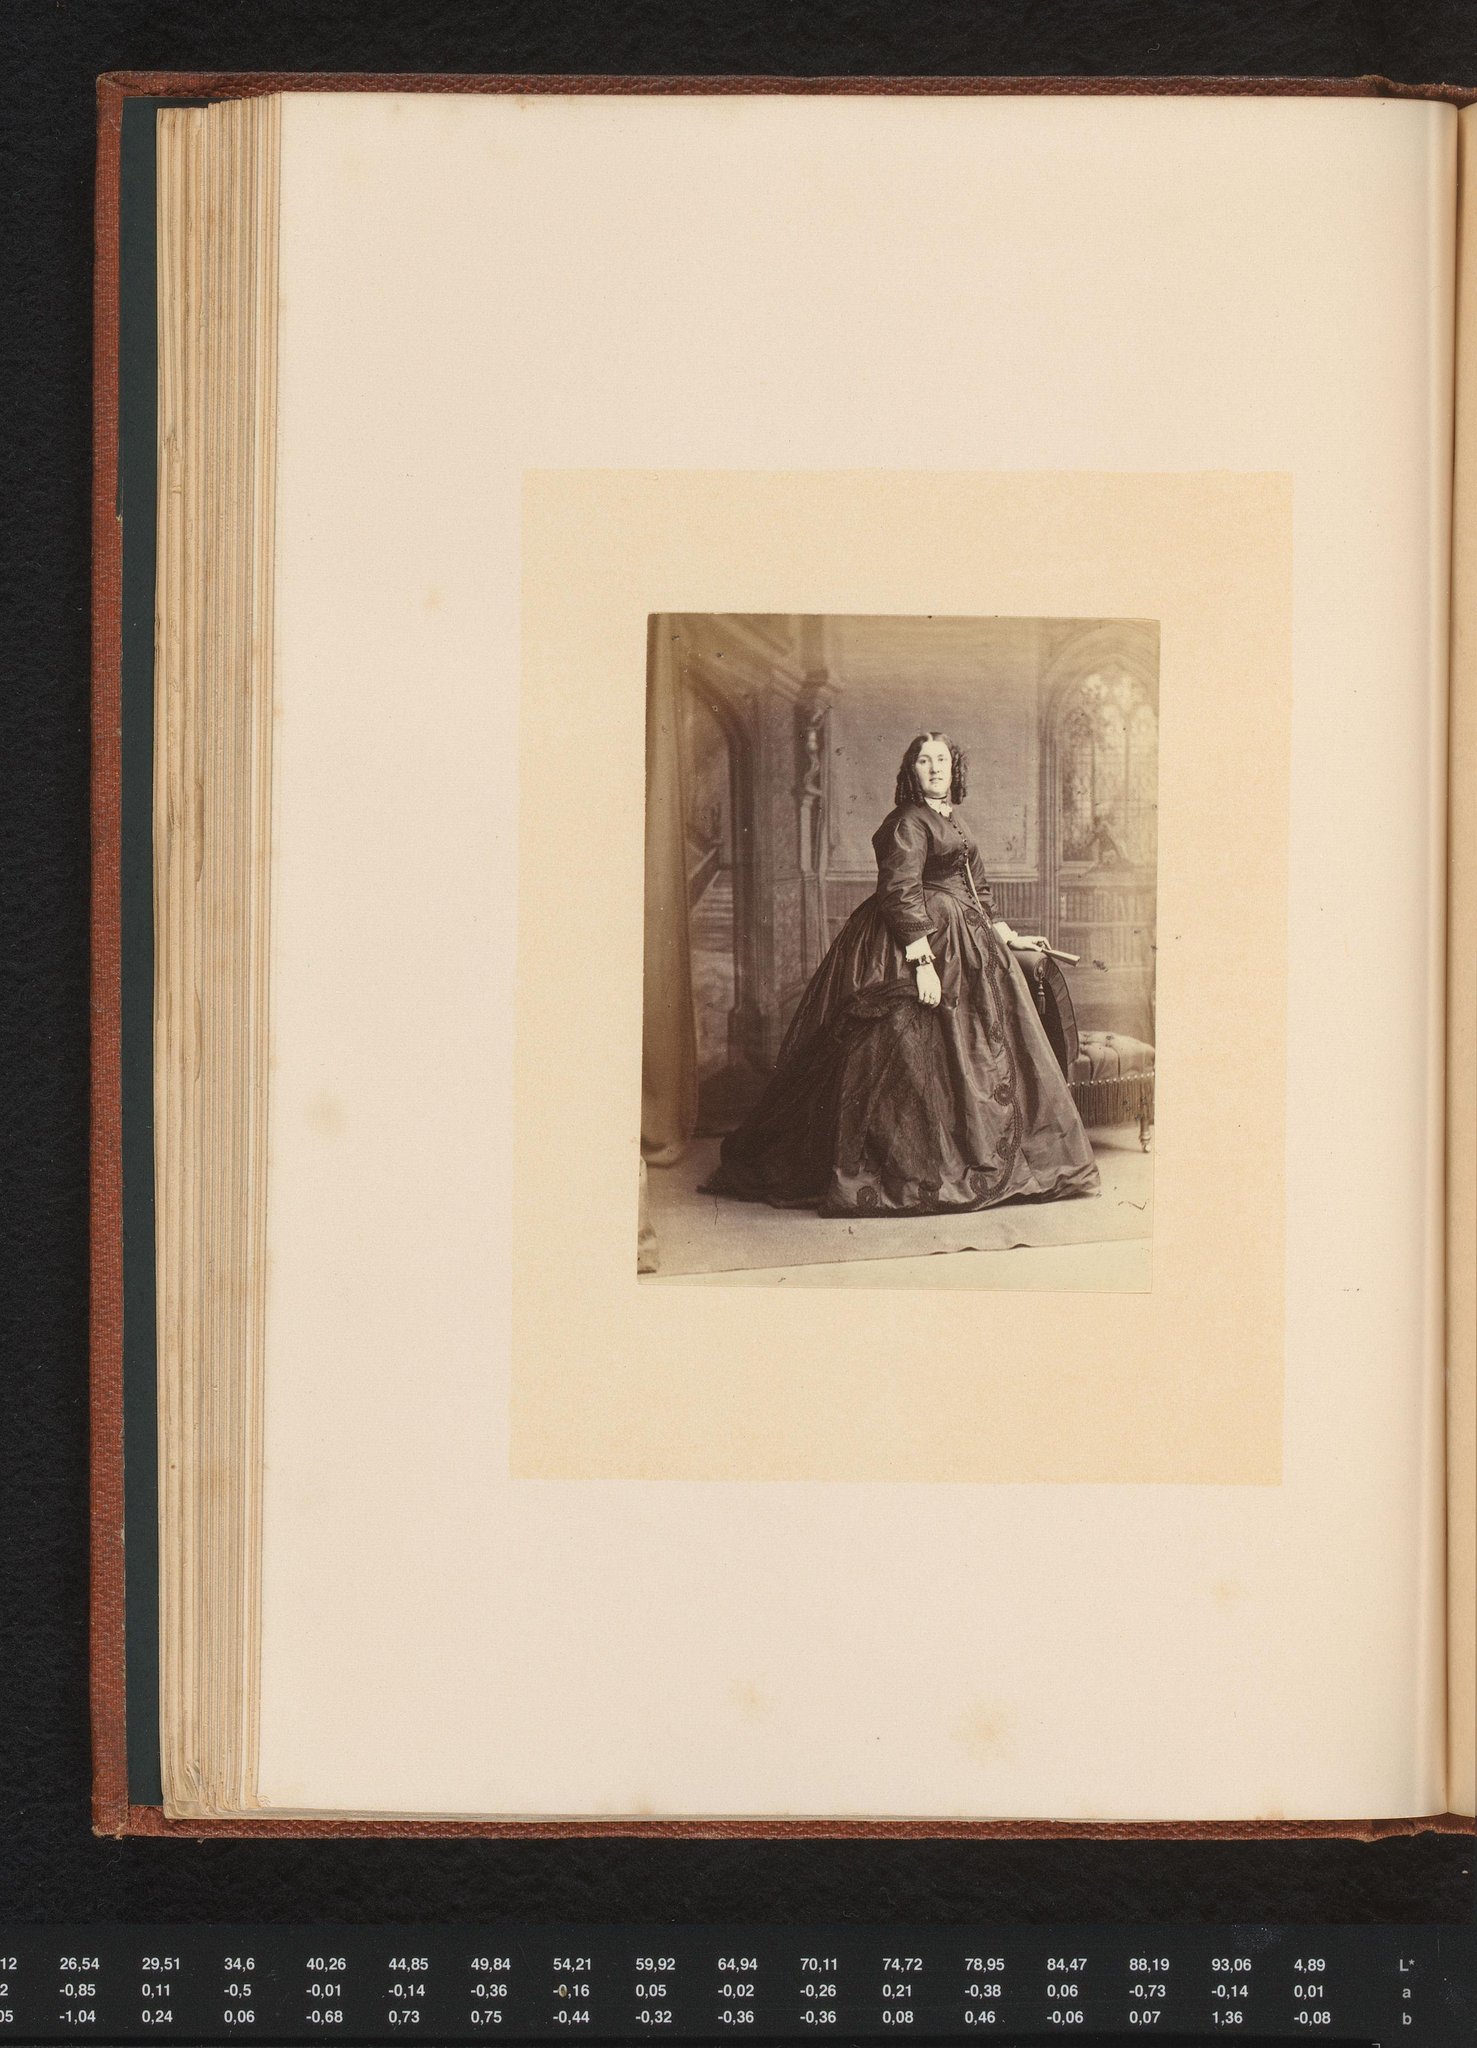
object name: page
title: Portret van Henrietta Ward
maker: ernest edwards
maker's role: fotograaf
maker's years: 1837-1903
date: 1861-1866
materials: paper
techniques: albumen print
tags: painter, historical persons - bb - woman